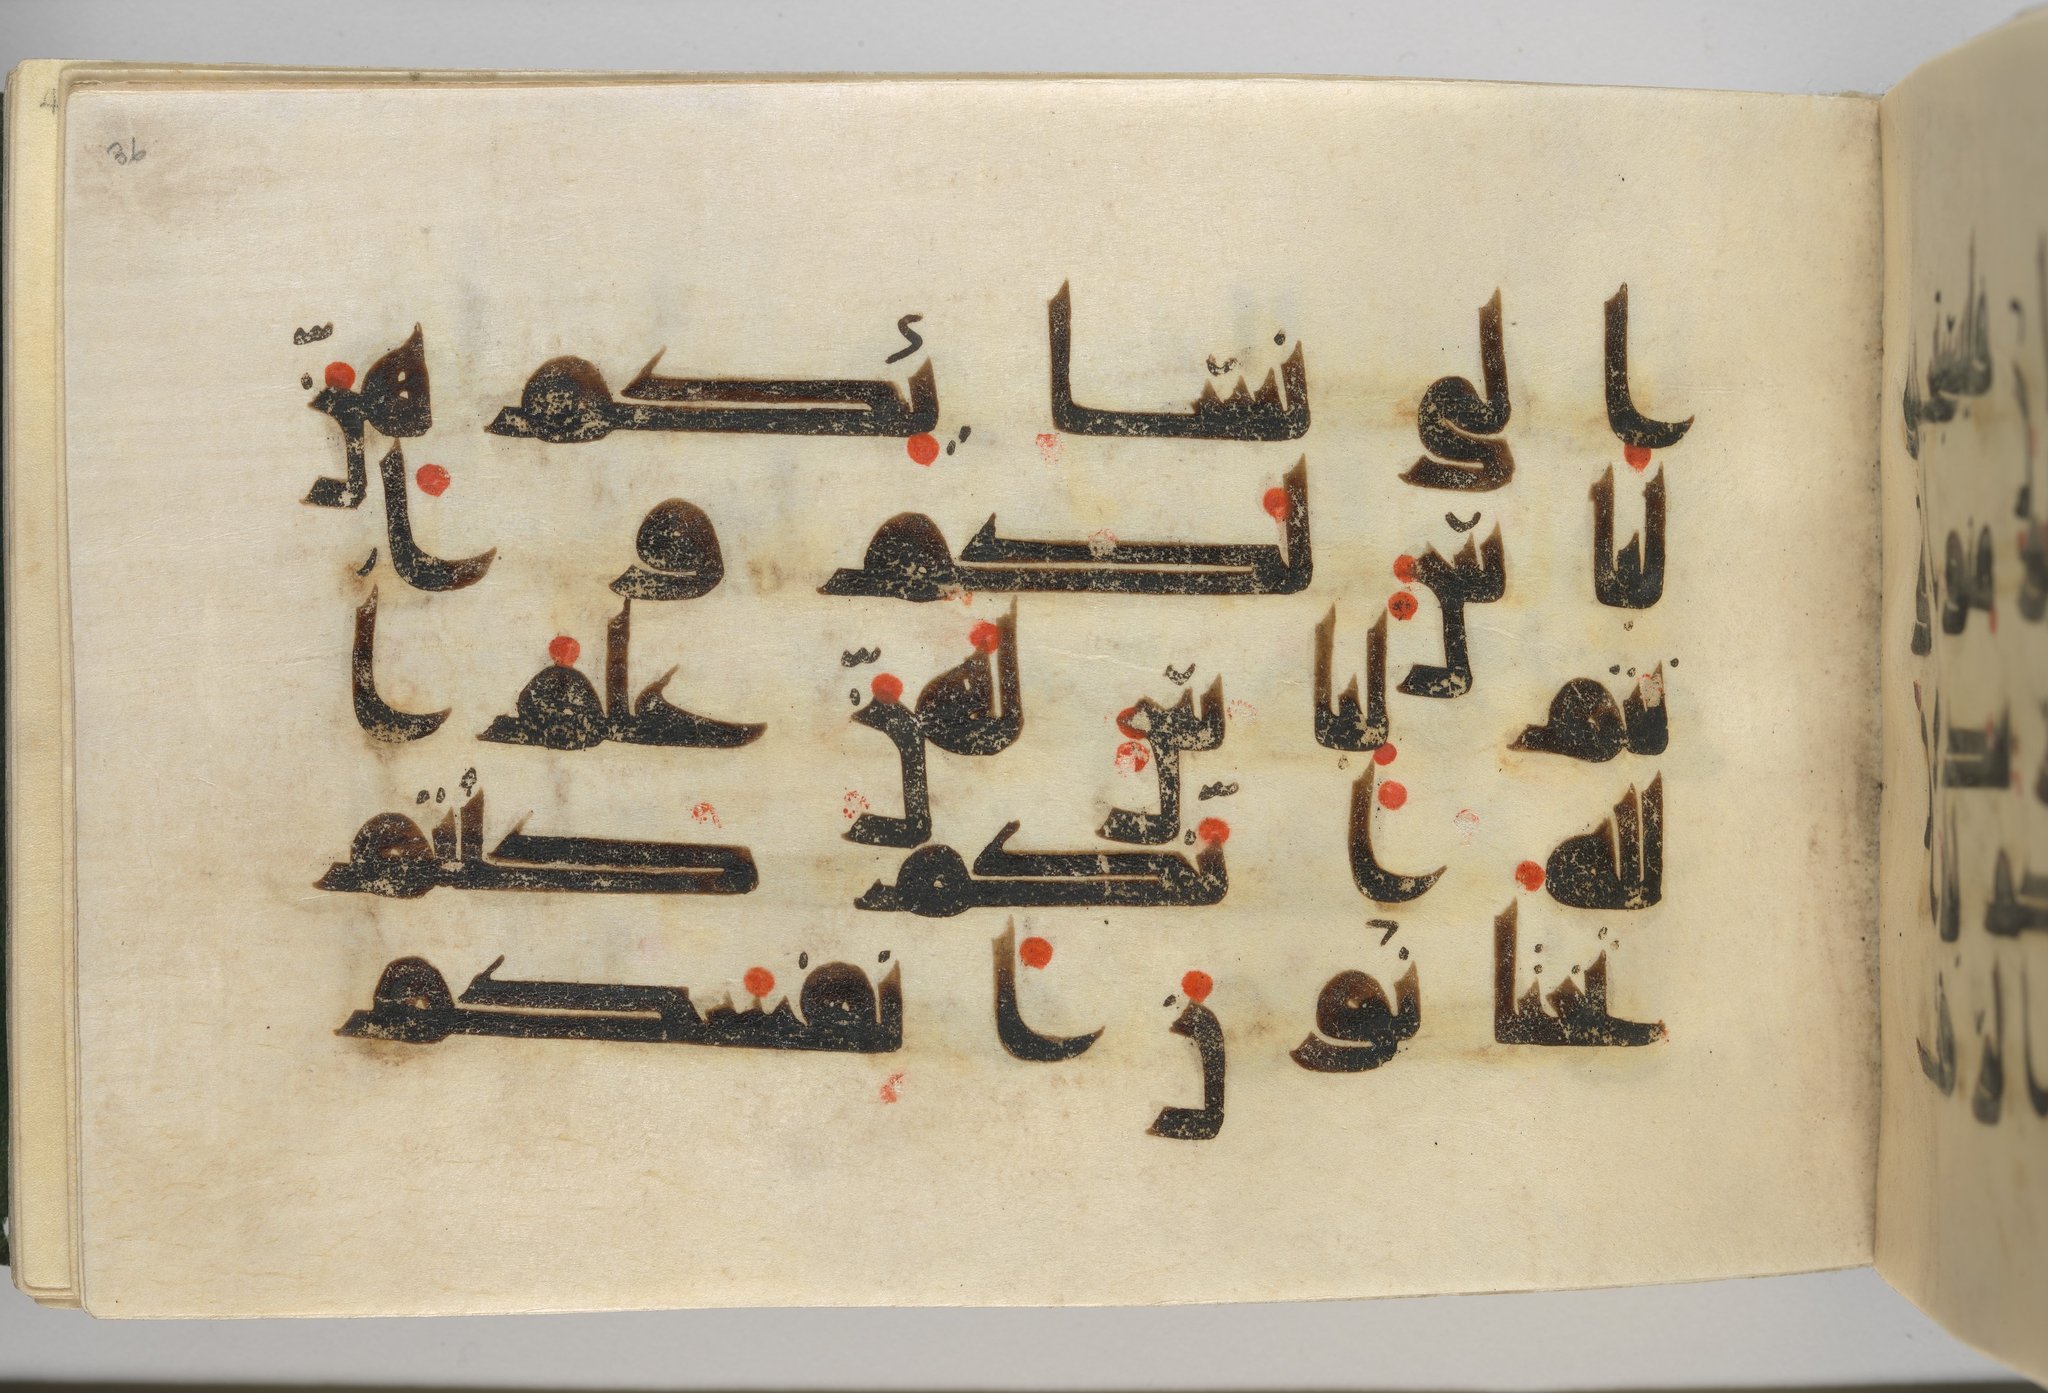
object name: non illustrated manuscript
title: Qur'an Manuscript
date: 867-933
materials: gold, ink, leather, parchment, watercolor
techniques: bookbinding, tooling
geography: syria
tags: qur'an